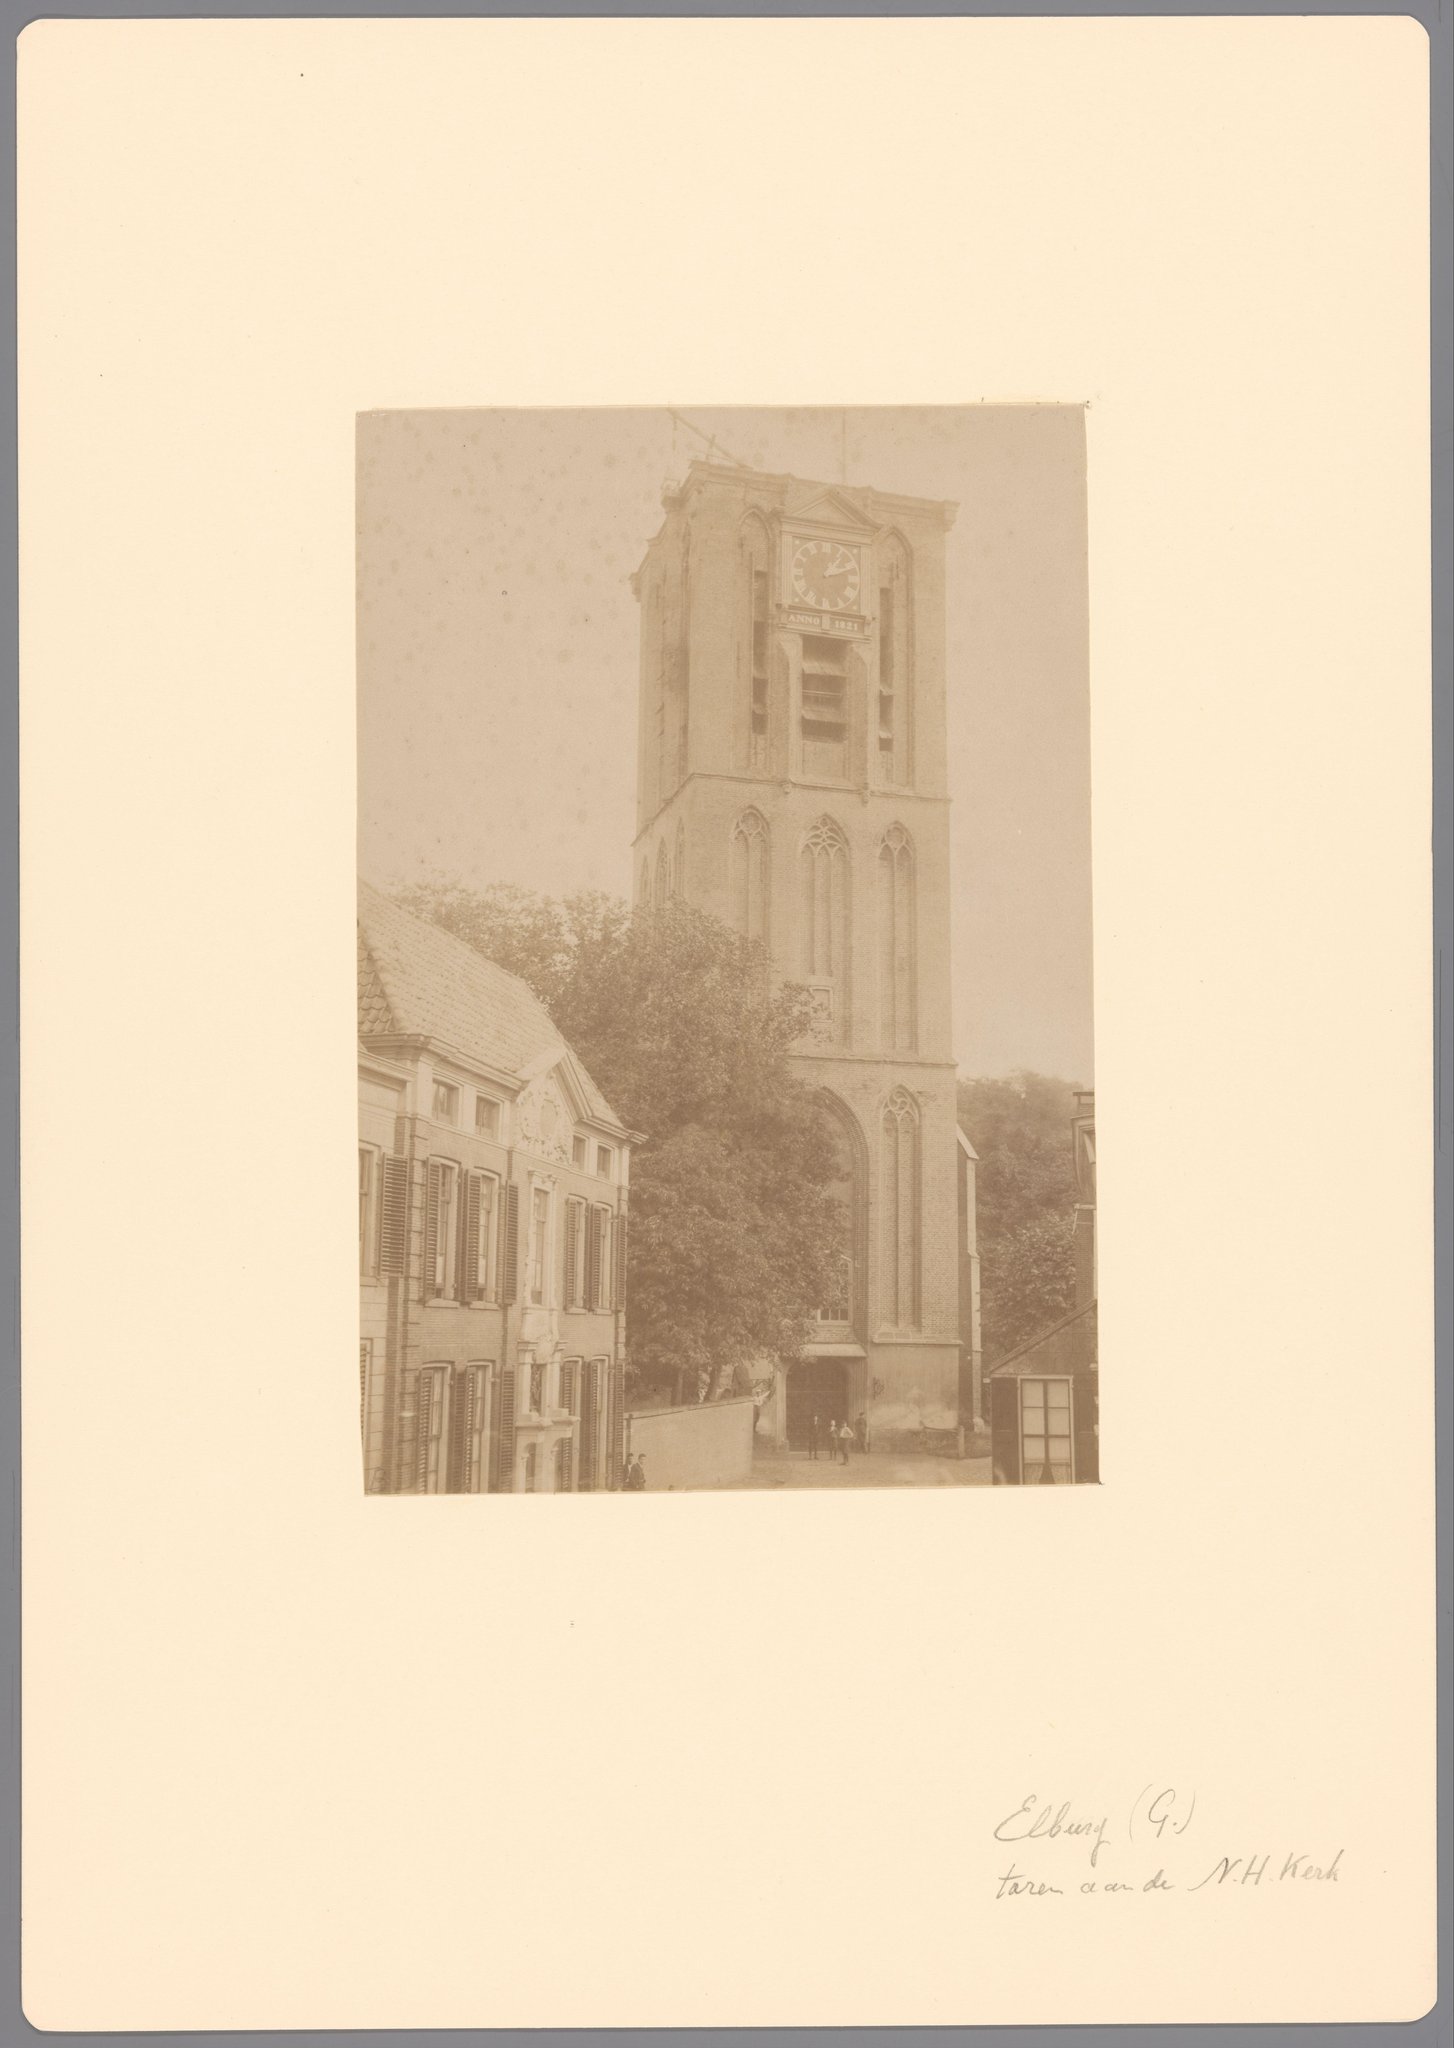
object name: photograph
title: Toren van de Grote of Sint-Nicolaaskerk te Elburg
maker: anoniem (monumentenzorg)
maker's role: fotograaf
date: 1890-1920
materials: cardboard, photographic support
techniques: albumen print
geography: elburg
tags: parts of church exterior and annexes: tower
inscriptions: annotation: ‘Elburg (G.)/ toren aan de N.H. Kerk’